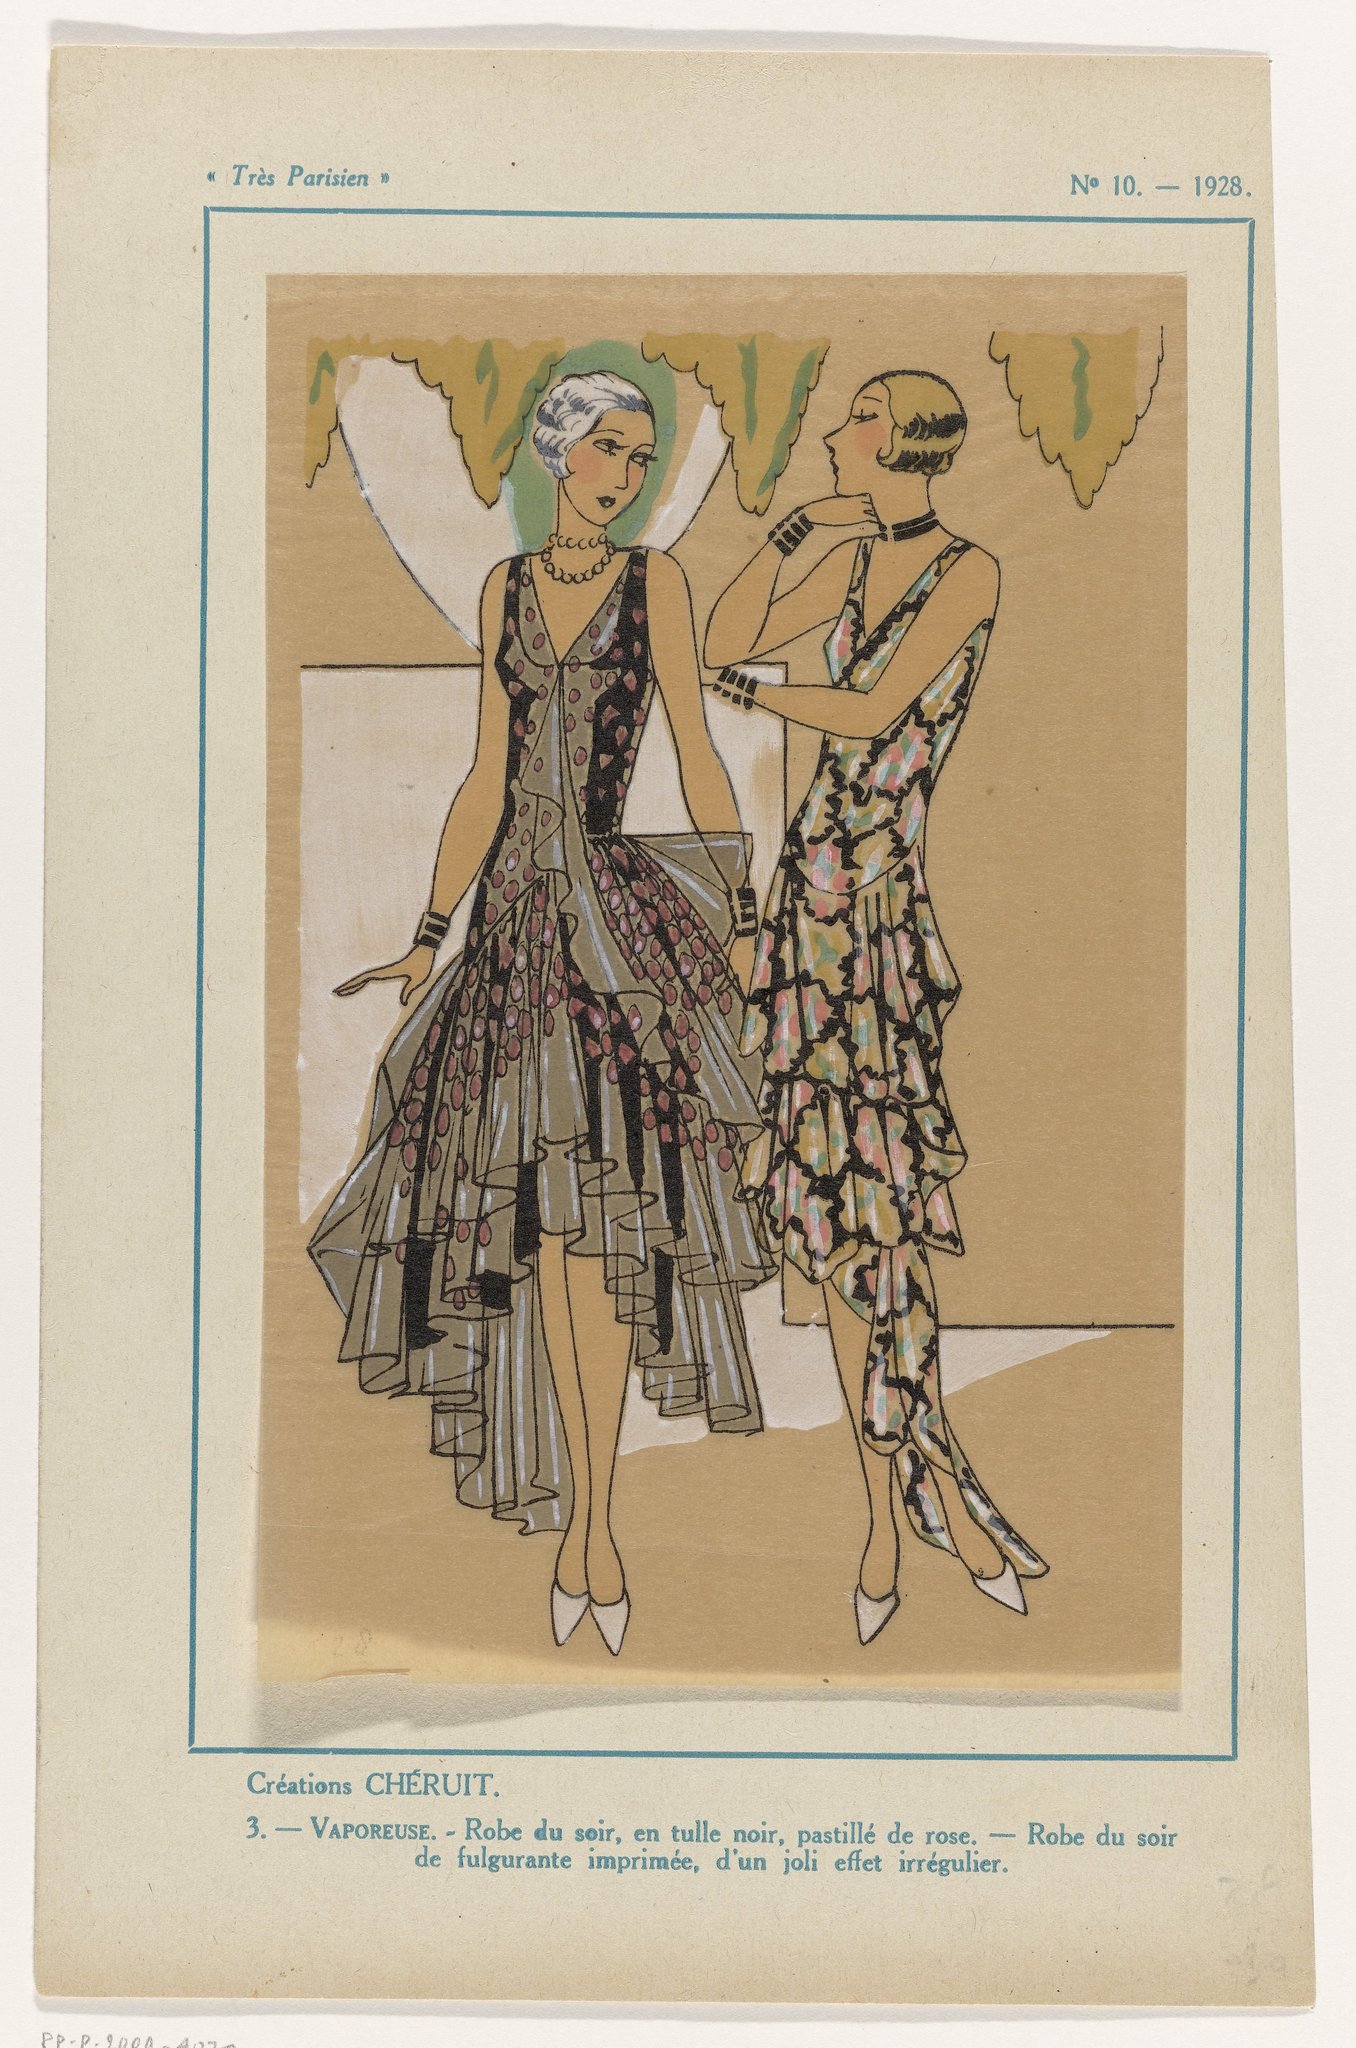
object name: fashion print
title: Très Parisien, 1928, No. 10 : Créations Chéruit / 3. - VAPOREUS (...)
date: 1928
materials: paper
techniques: hand coloring, letterpress printing, lithography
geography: paris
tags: dress, gown: evening dress (+ women's clothes), fashion plates, bracelet, wristlet (+ women's clothes), necklace (+ women's clothes)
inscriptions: title: ‘"Très Parisien". / No 10. - 1928’, caption: ‘Créations CHÉRUIT. / 3. - VAPOREUSE. - Robe du soir, en tulle noir, pastillé de rose. - Robe du soir de fulgurante imprimée, d'un joli effet irrégulier.’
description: Ontwerpen van Chéruit. Avondjurk van zwarte tule met roze stippen. Avondjurk van bedrukte 'fulgurante'. Accessoires: collier, armbanden, schoenen met puntige neuzen. Prent uit het modetijdschrift Très Parisien (1920-1936).